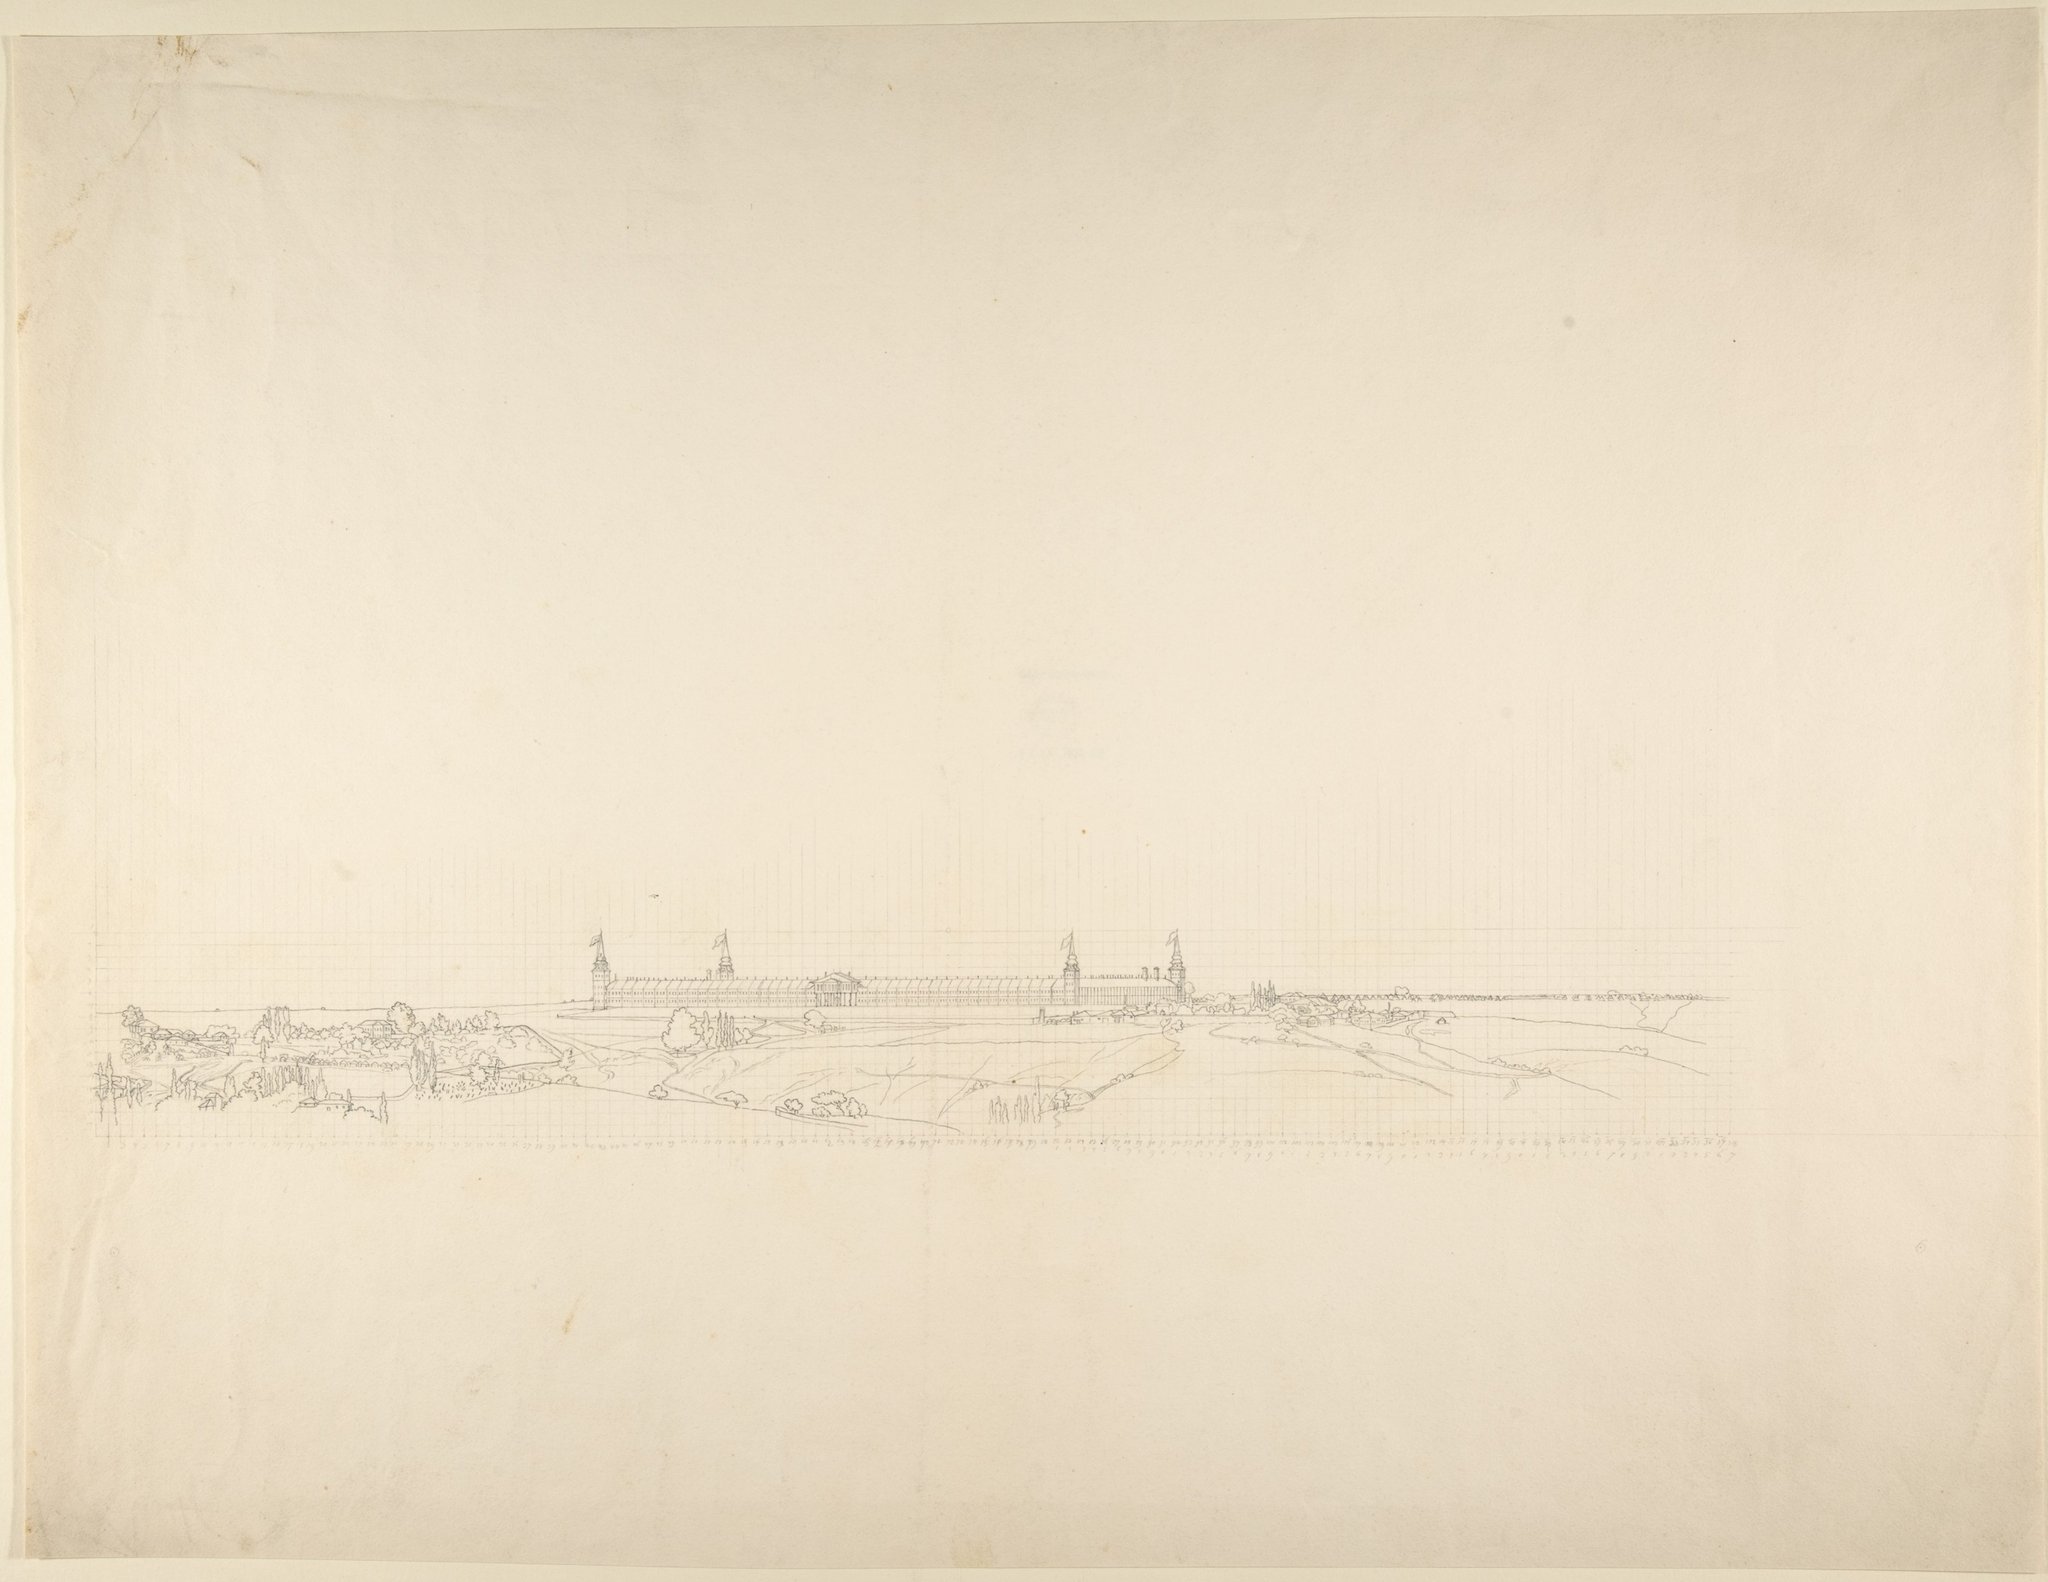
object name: drawing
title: Landscape with a Large Building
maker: franz von hauslab the younger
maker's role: artist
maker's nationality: austrian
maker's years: 1798-1883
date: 1818-1883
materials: graphite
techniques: drawing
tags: buildings,houses,landscapes,trees,flags